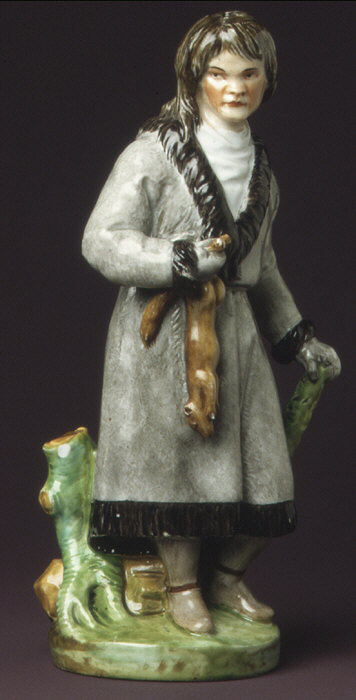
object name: figure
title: Man from Kamchatka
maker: imperial porcelain manufactory, st. petersburg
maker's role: manufactory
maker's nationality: russian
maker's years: 1744-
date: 1780-1800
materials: hard paste porcelain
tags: animals,men